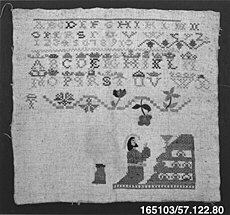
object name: sampler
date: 1801-1900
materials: linen, silk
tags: men,flowers